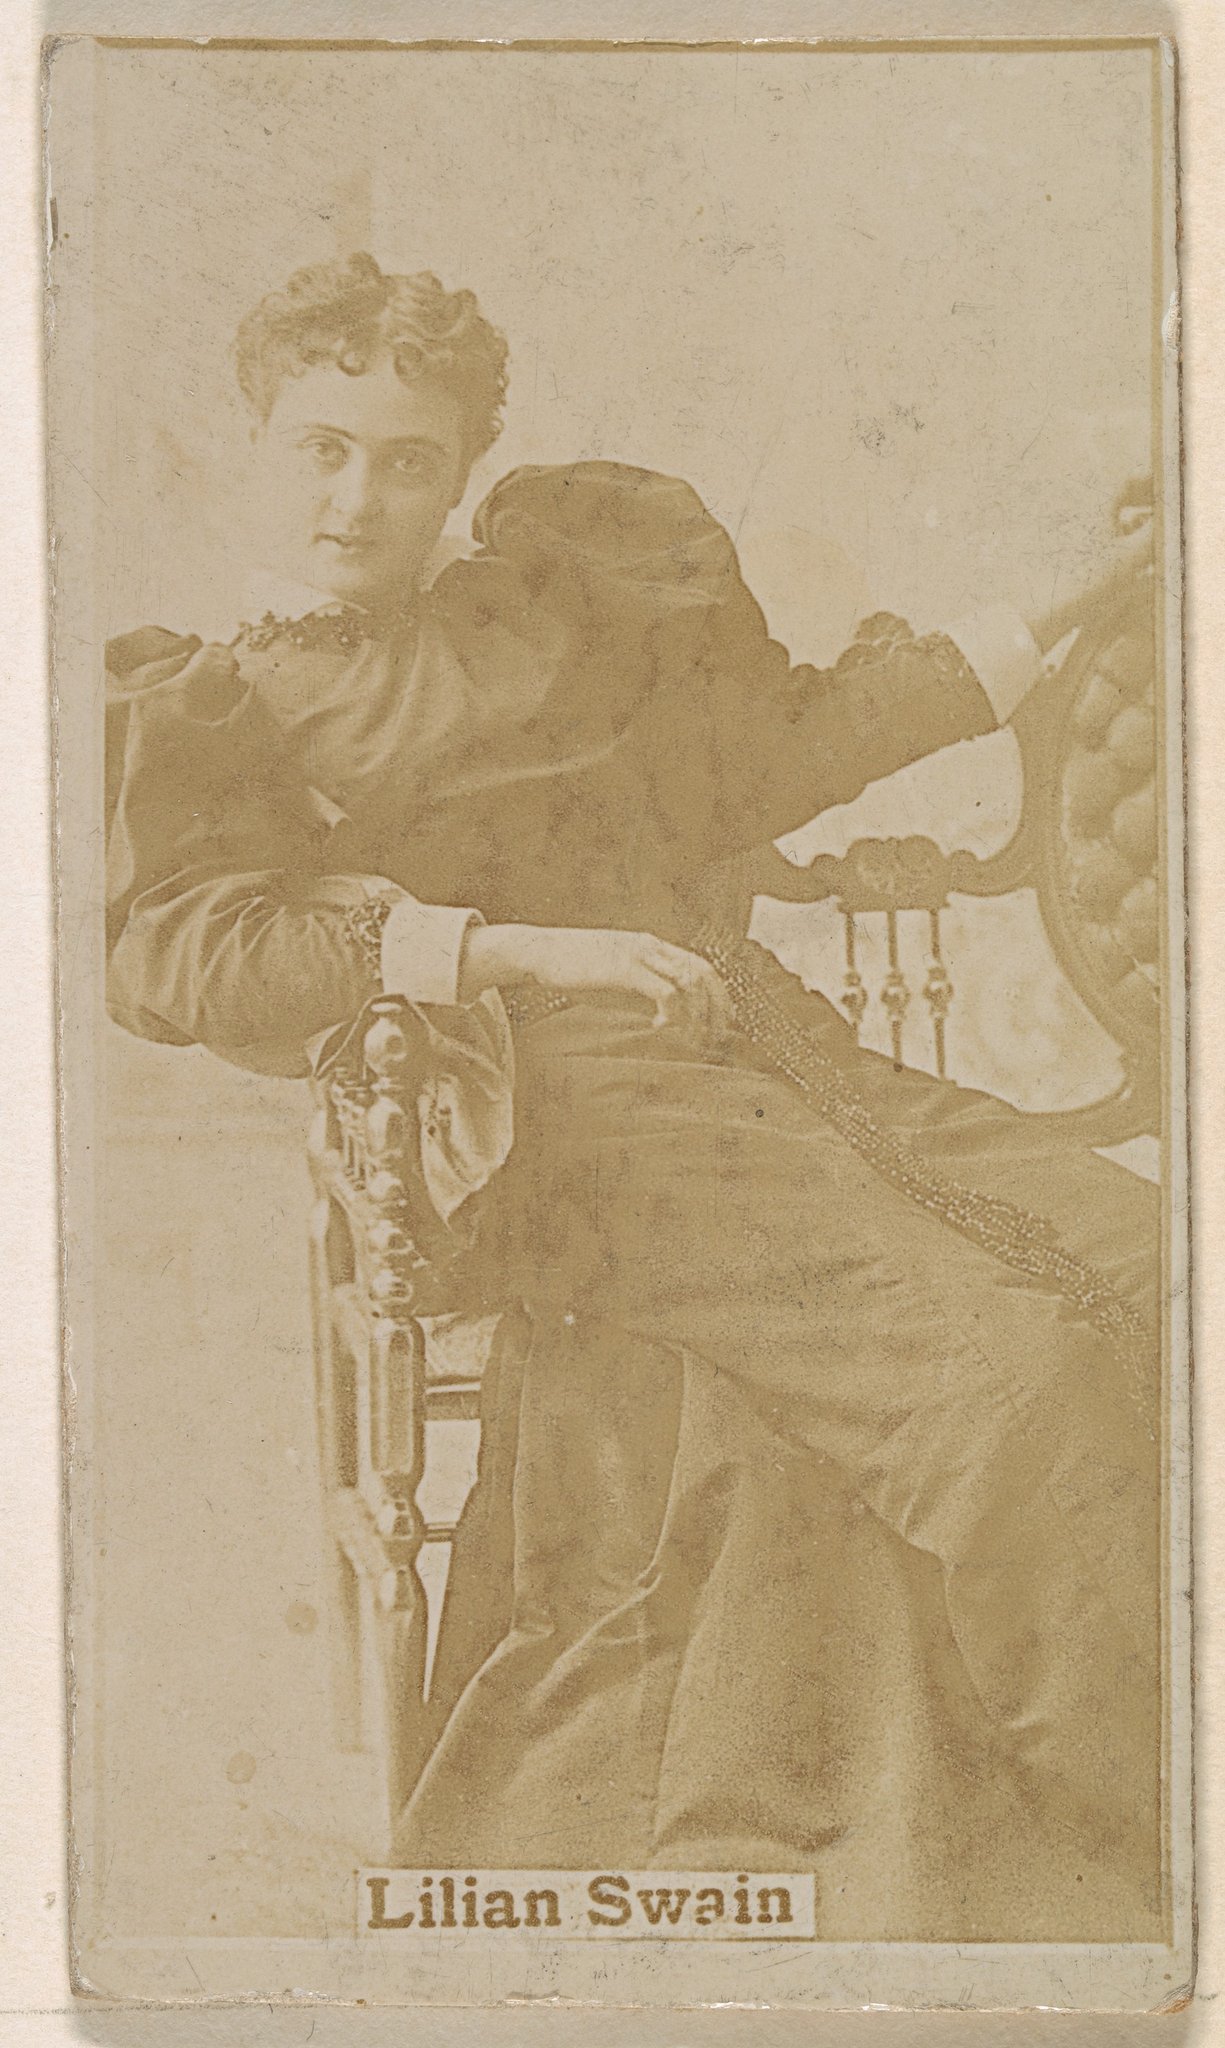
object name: photograph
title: Lilian Swain, from the Actresses series (N245) issued by Kinney Brothers to promote Sweet Caporal Cigarettes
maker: kinney brothers tobacco company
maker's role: publisher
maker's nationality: american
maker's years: 1869-2011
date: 1890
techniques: albumen silver print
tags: portraits,women,actresses